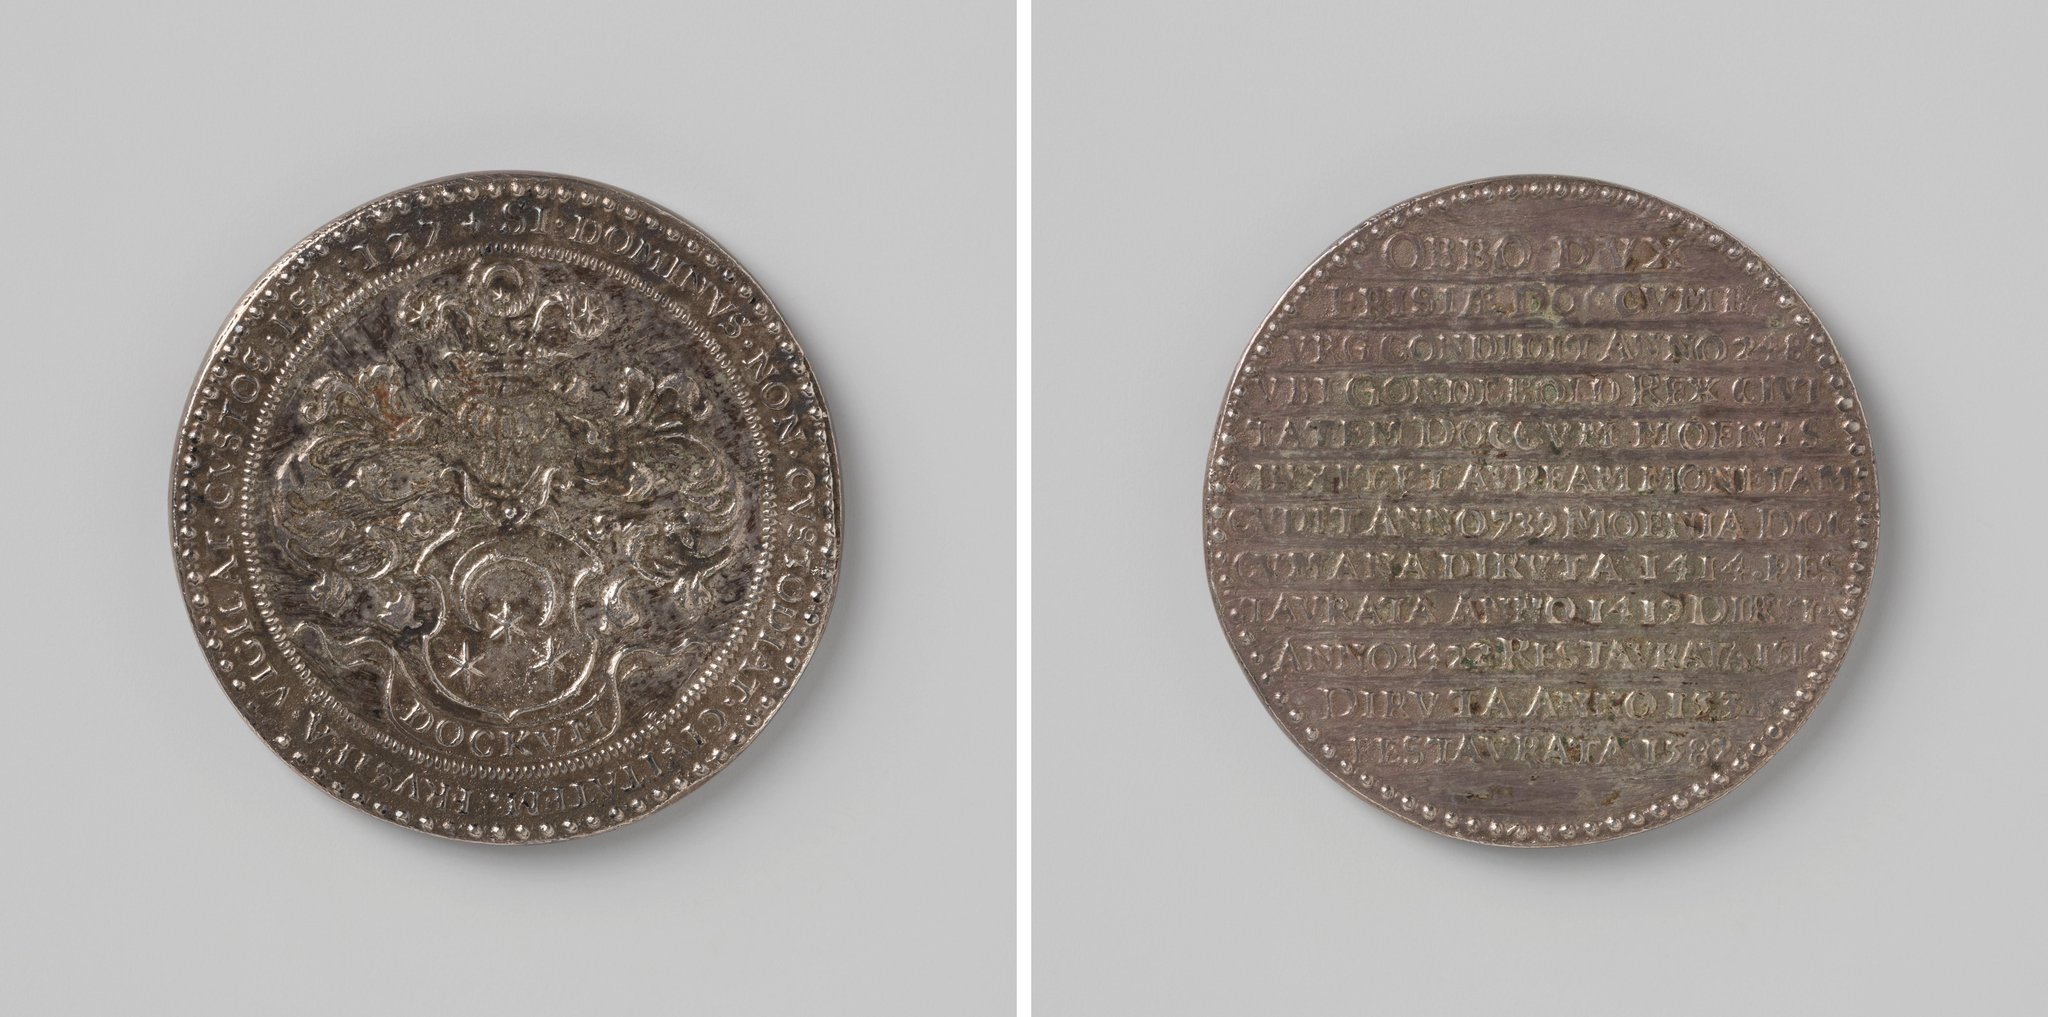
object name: triomfpenning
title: Herstel van de vestingwerken te Dokkum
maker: Anonymous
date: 1582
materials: silver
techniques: striking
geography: leeuwarden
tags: dokkum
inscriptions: circumscription: ‘SI DOMINVS NON CVSTODIAT CIVITATEM FRVSTRA VIGILAT CUSTOS PSA 127 / DOCKVM’, inscription: ‘OBBO DVX FRISIAE DOCCVMBVRG CONDIDIT ANNO 248 VBI GONDEBOLD REX CIVITATEM DOCCVM MOENYS CINXIT ET AVREAM MONETAM CVDIT ANNO 739 MOENIA DOCCVMANA DIRVTA 1414 RESTAVRATA ANNO 1419 DIRVTA ANNO 1422 RESTAVRATA 1516 DIRVTA ANNO 1531 RESTAVRATA 1582’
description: Zilveren penning. Voorzijde: gehelmd wapenschild binnen omschrift. Keerzijde: opschrift.